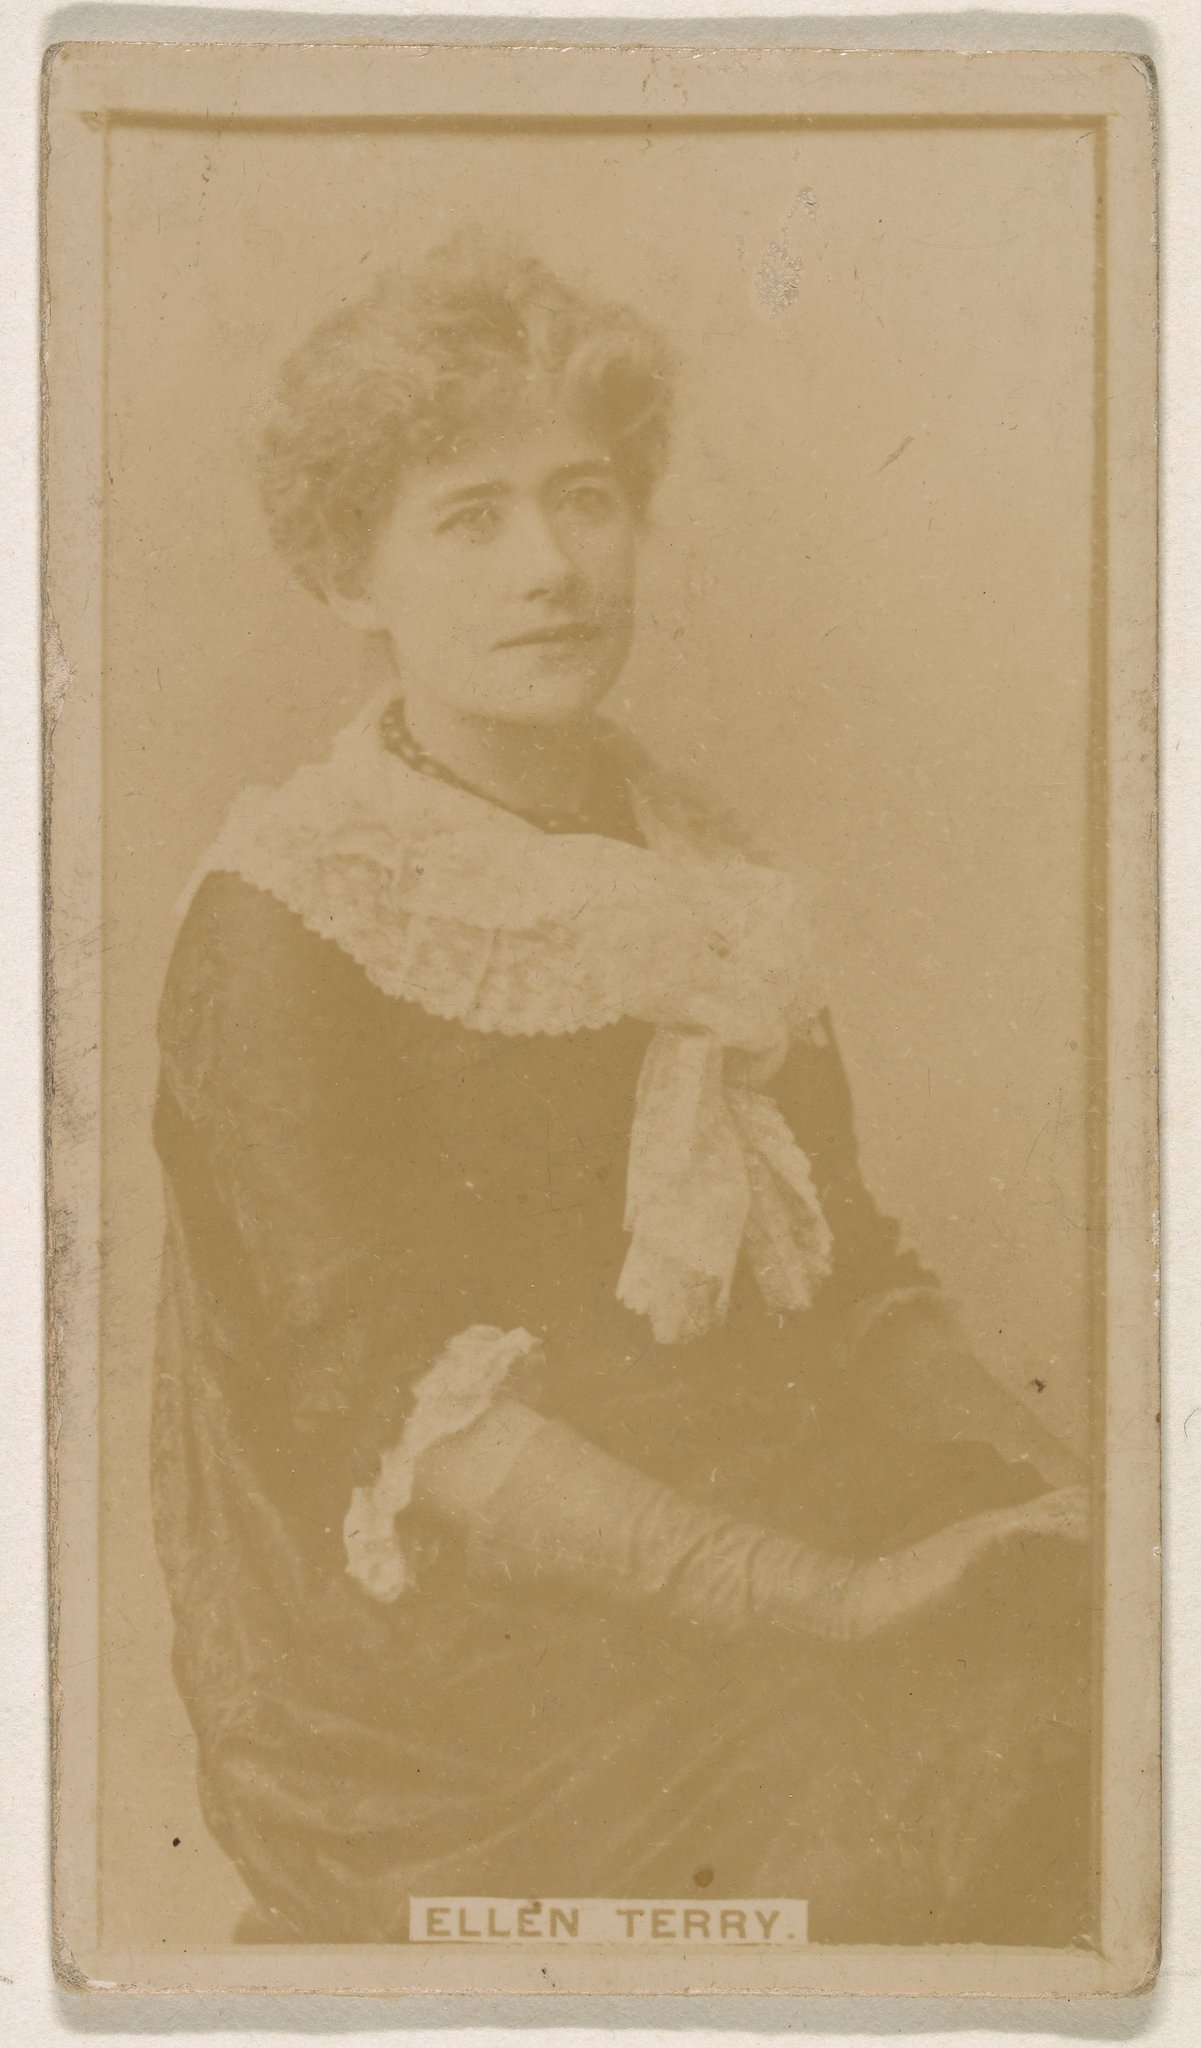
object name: photograph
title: Ellen Terry, from the Actresses series (N245) issued by Kinney Brothers to promote Sweet Caporal Cigarettes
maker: kinney brothers tobacco company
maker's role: publisher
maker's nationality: american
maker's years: 1869-2011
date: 1890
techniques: albumen silver print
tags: portraits,women,actresses